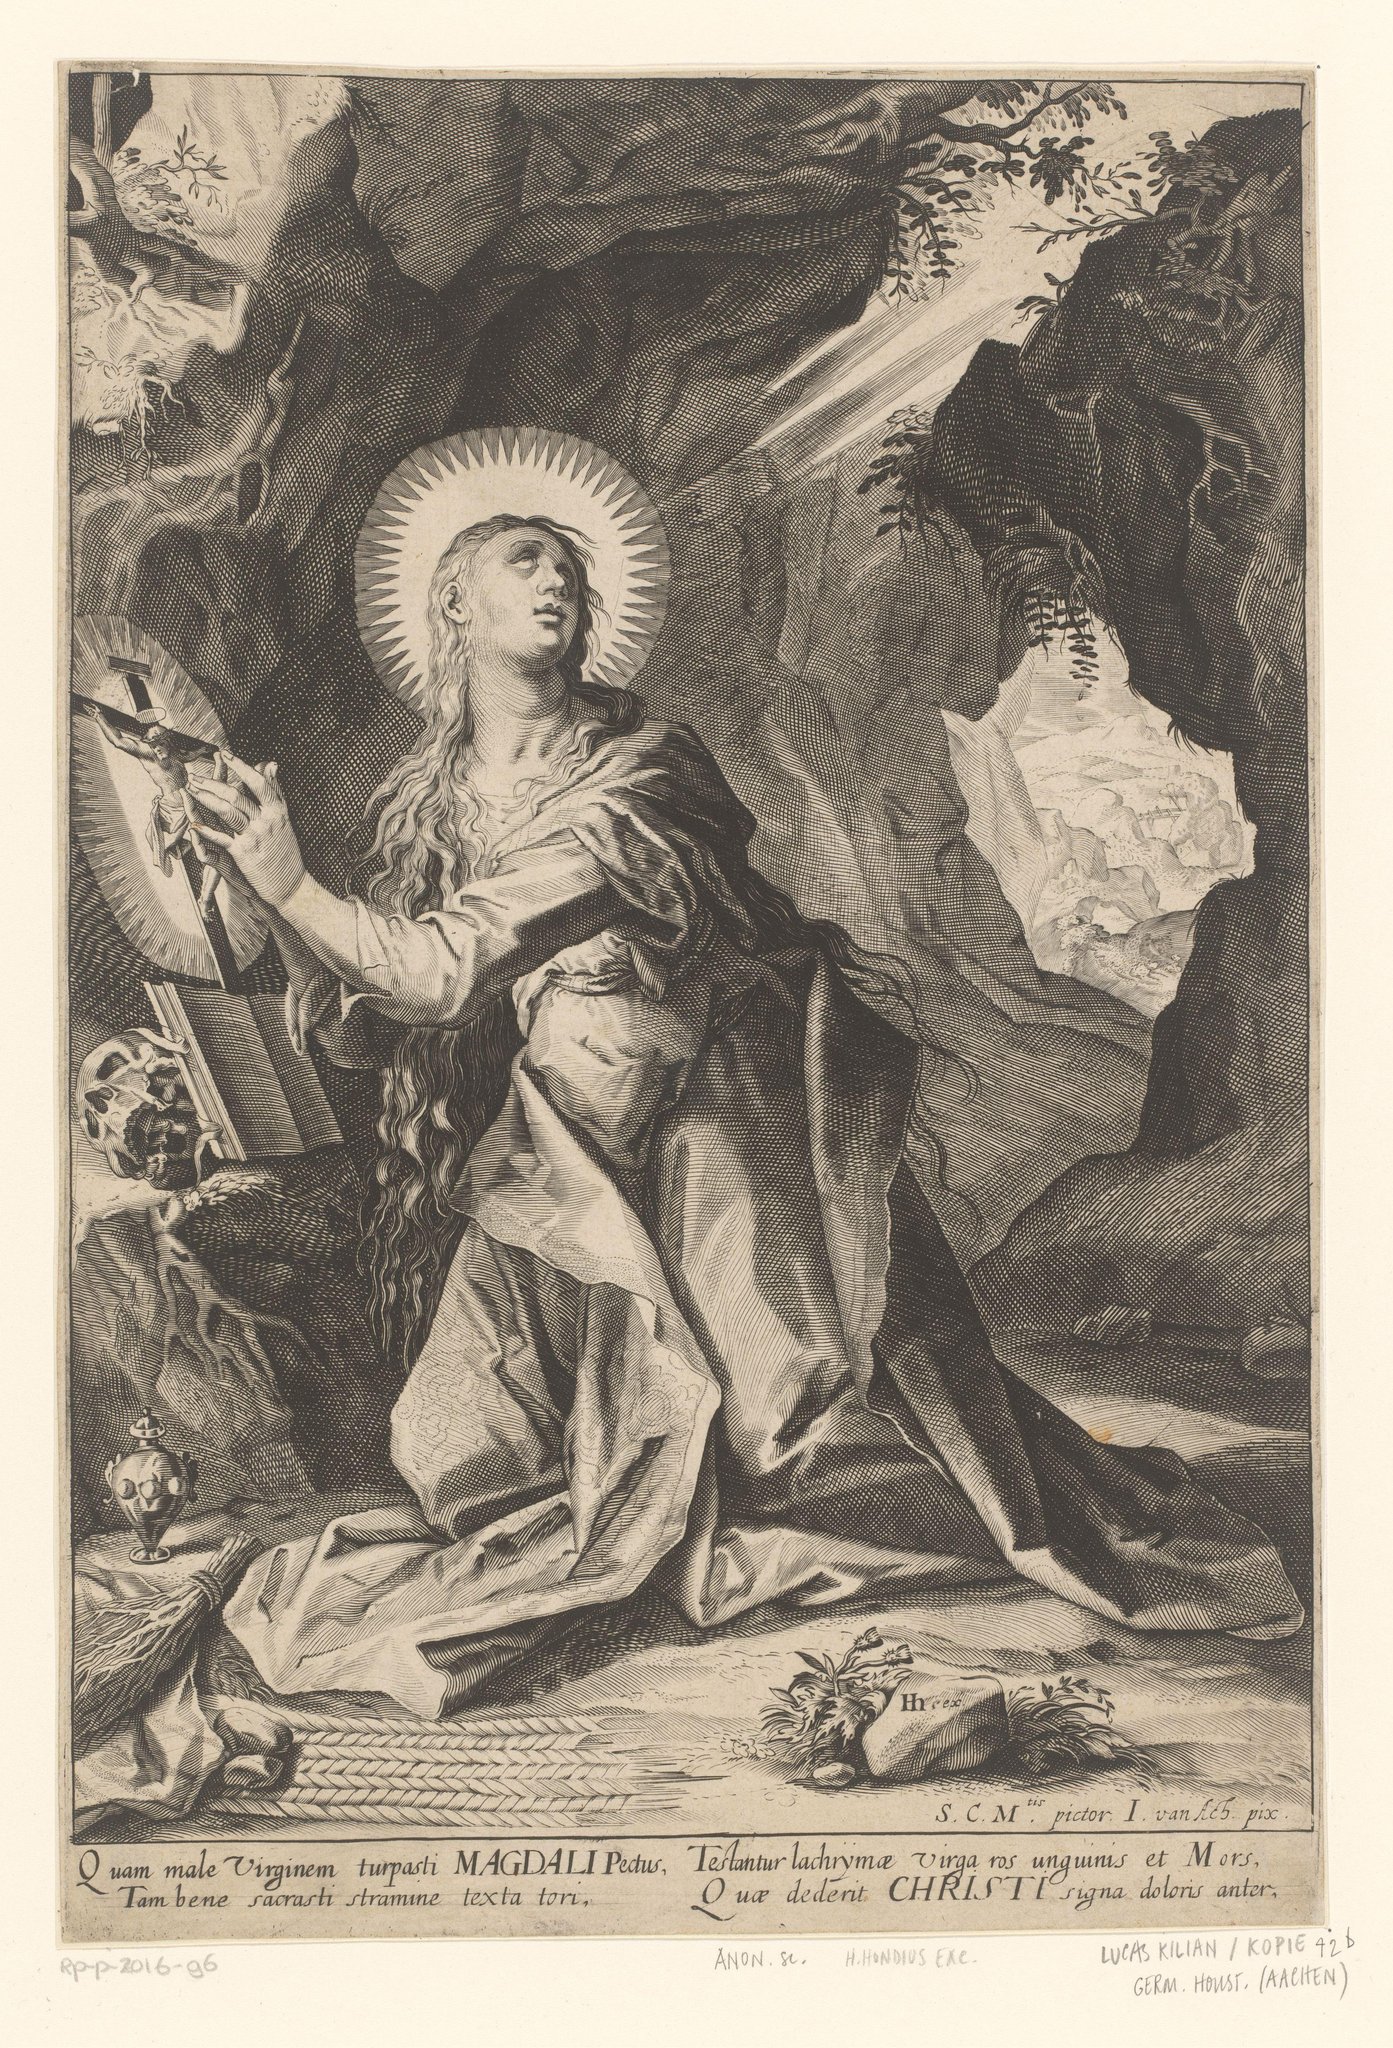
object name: print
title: Boetvaardige Maria Magdalena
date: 1588-1650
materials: paper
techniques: engraving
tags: (human) skull, the penitent harlot mary magdalene; possible attributes: book (or scroll), crown, crown of thorns, crucifix, jar of ointment, mirror, musical instrument, palm-branch, rosary, scourge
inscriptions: collector's mark: Lugt 2028, collector's mark: Lugt 2228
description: De heilige Maria Magdalena knielend voor een opengeslagen boek en een crucifix. In de ondermarge vier regels Latijnse tekst.